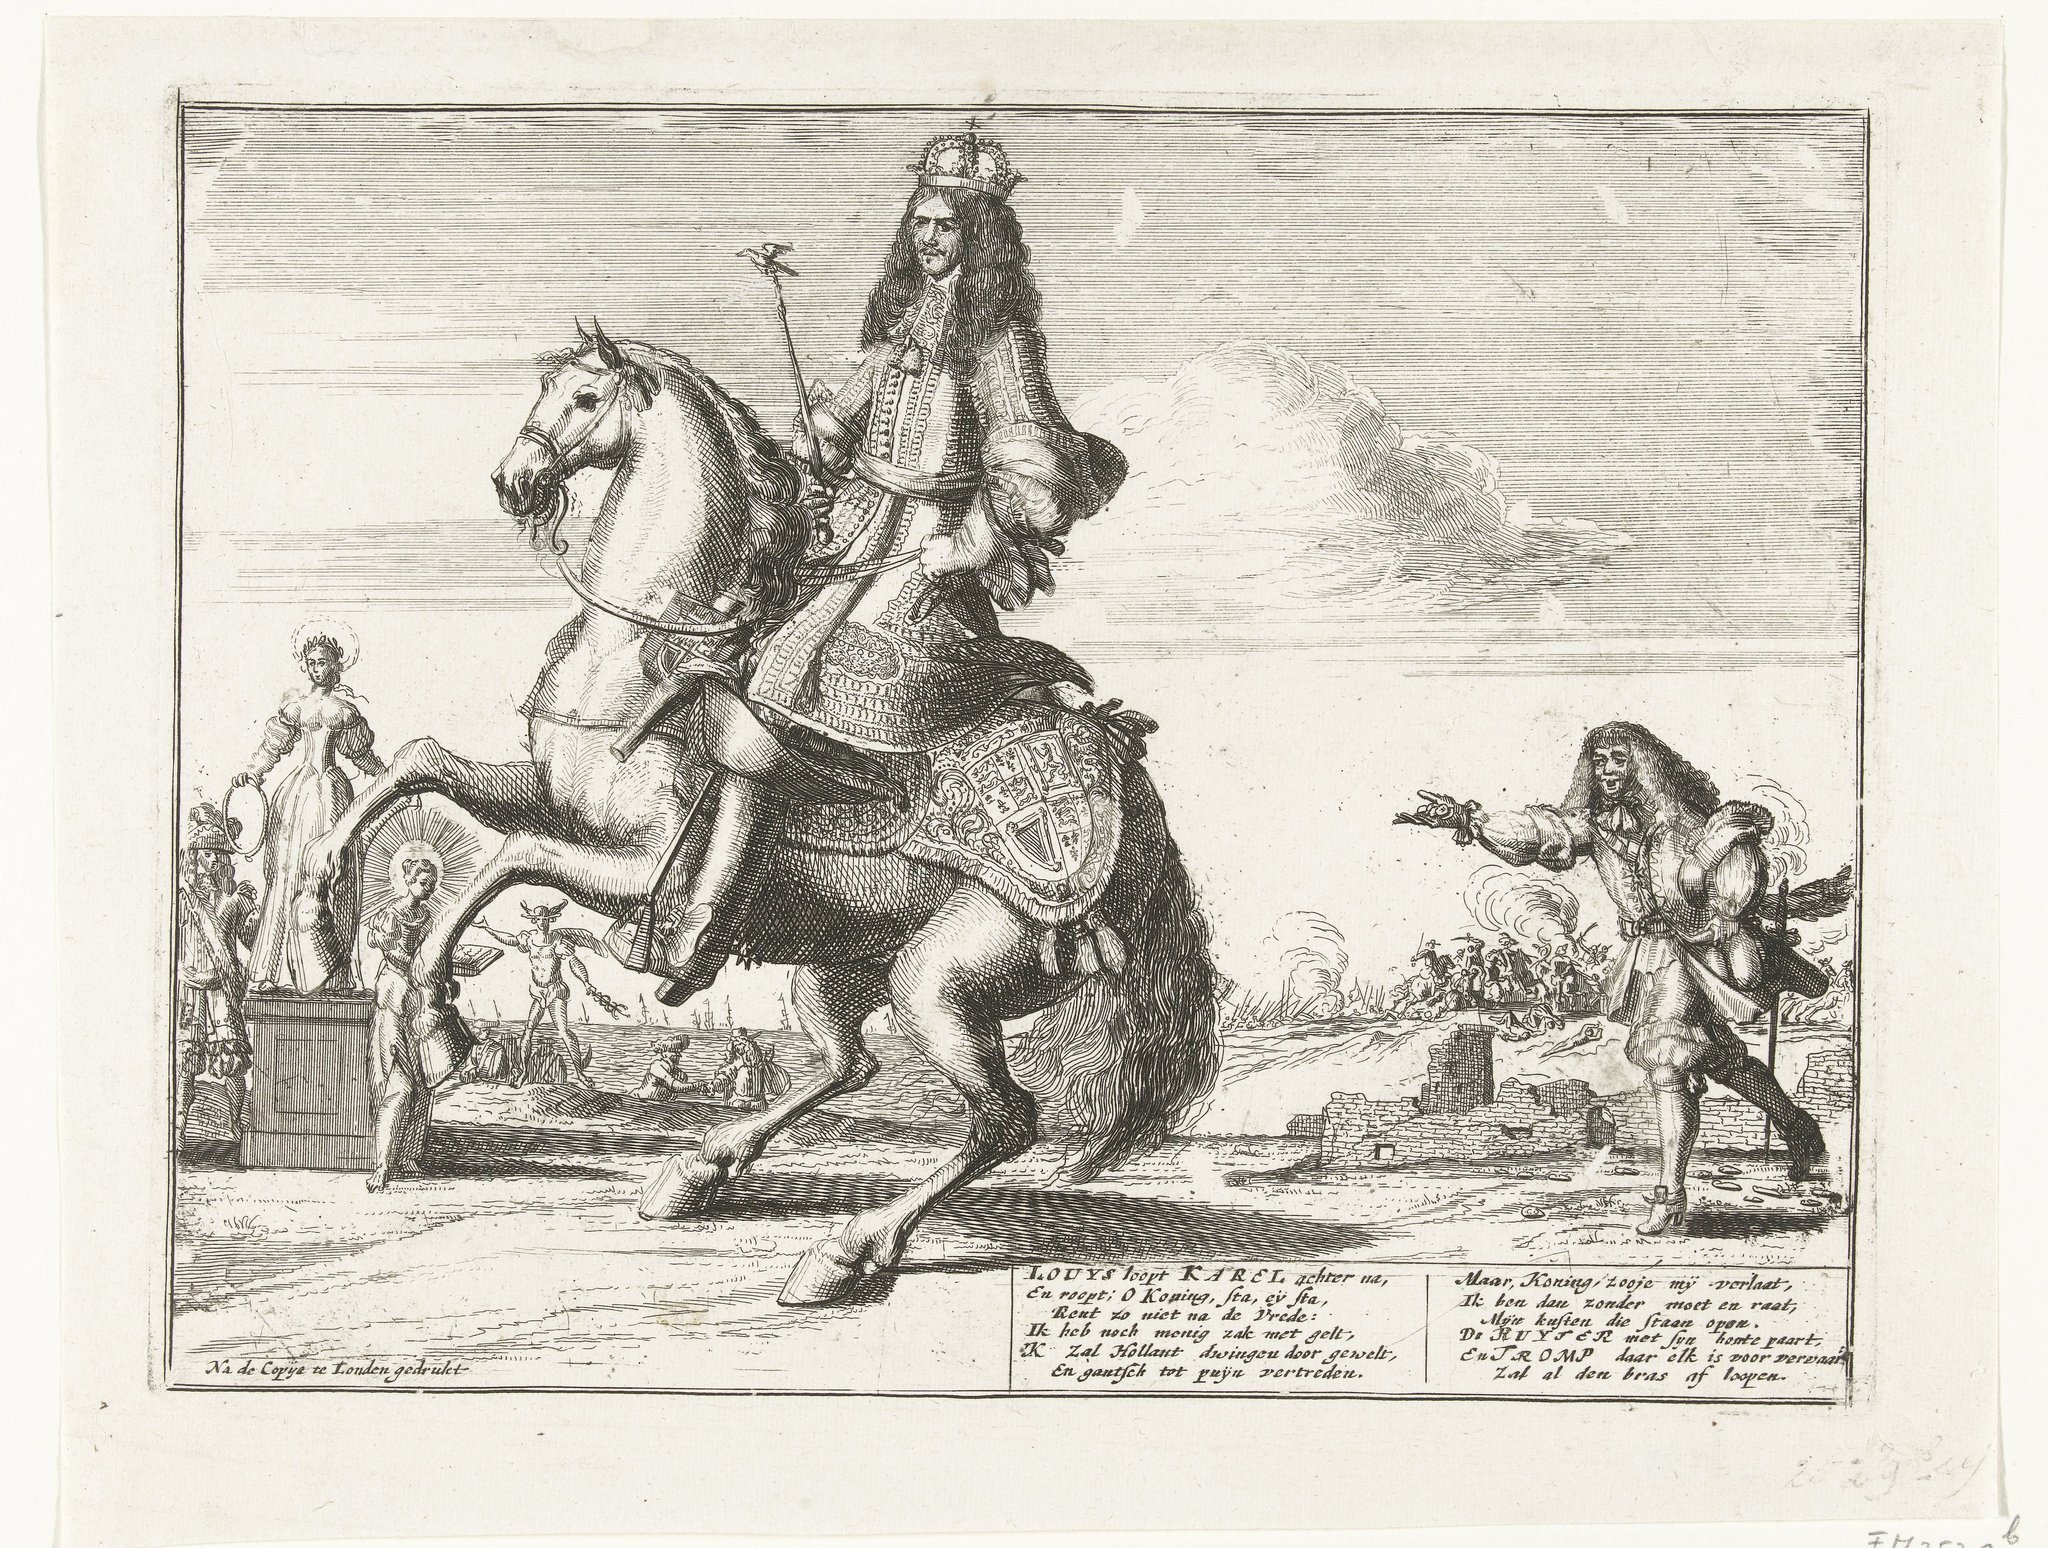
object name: print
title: Spotprent op de pogingen van Frankrijk om de vredeshandel van Engeland met de Republiek te verhinderen, 1674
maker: Anonymous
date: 1674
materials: paper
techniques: etching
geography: northern netherlands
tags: lodewijk xiv (koning van frankrijk), london, karel ii (koning van engeland), political caricatures and satires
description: Spotprent op de pogingen van Frankrijk om de vredeshandel van Engeland met de Republiek te verhinderen, 1674. Koning Karel II van Engeland te paard, rechts loopt de Franse koning Lodewijk XIV beladen met geldzakken hem achterna. Links de Vrede op een voetstuk staande tussen een krijgsman en Godsdienst. Met twee verzen van 6 regels in de plaat. Onderaan links vermeld: Na de Copye te Londen gedruckt.